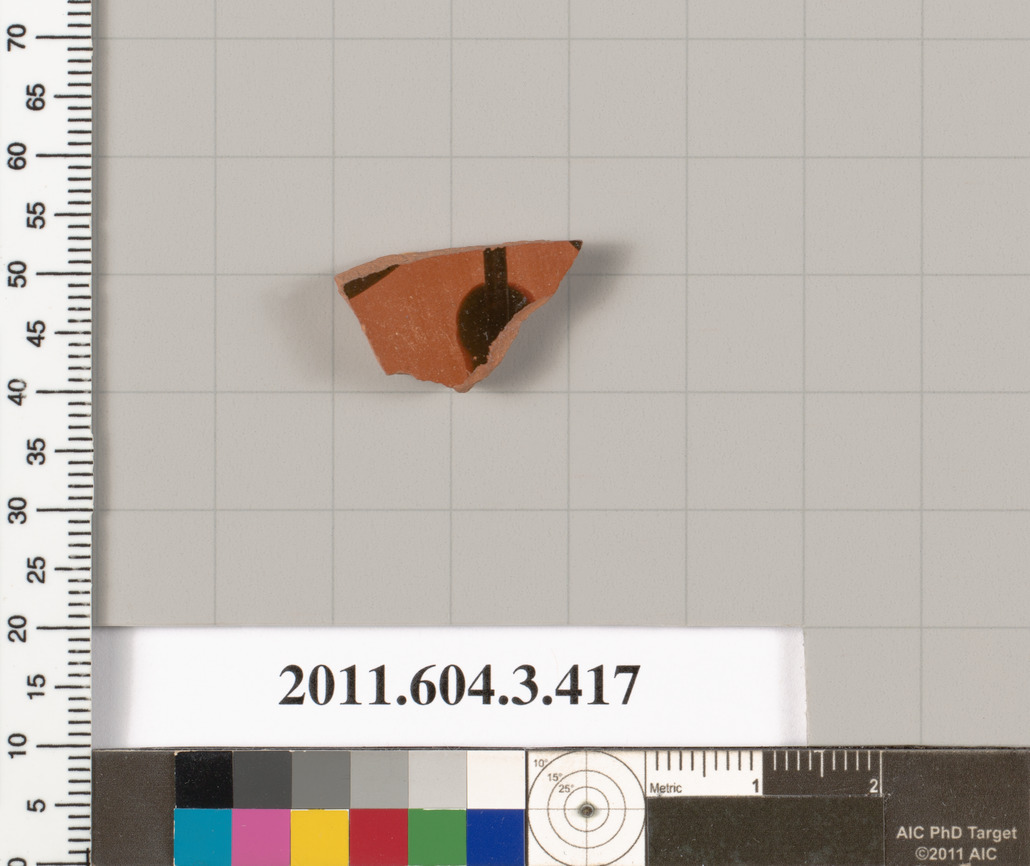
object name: neck amphora fragment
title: Terracotta fragment of a neck-amphora (jar)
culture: greek, attic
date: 534-468 BCE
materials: terracotta